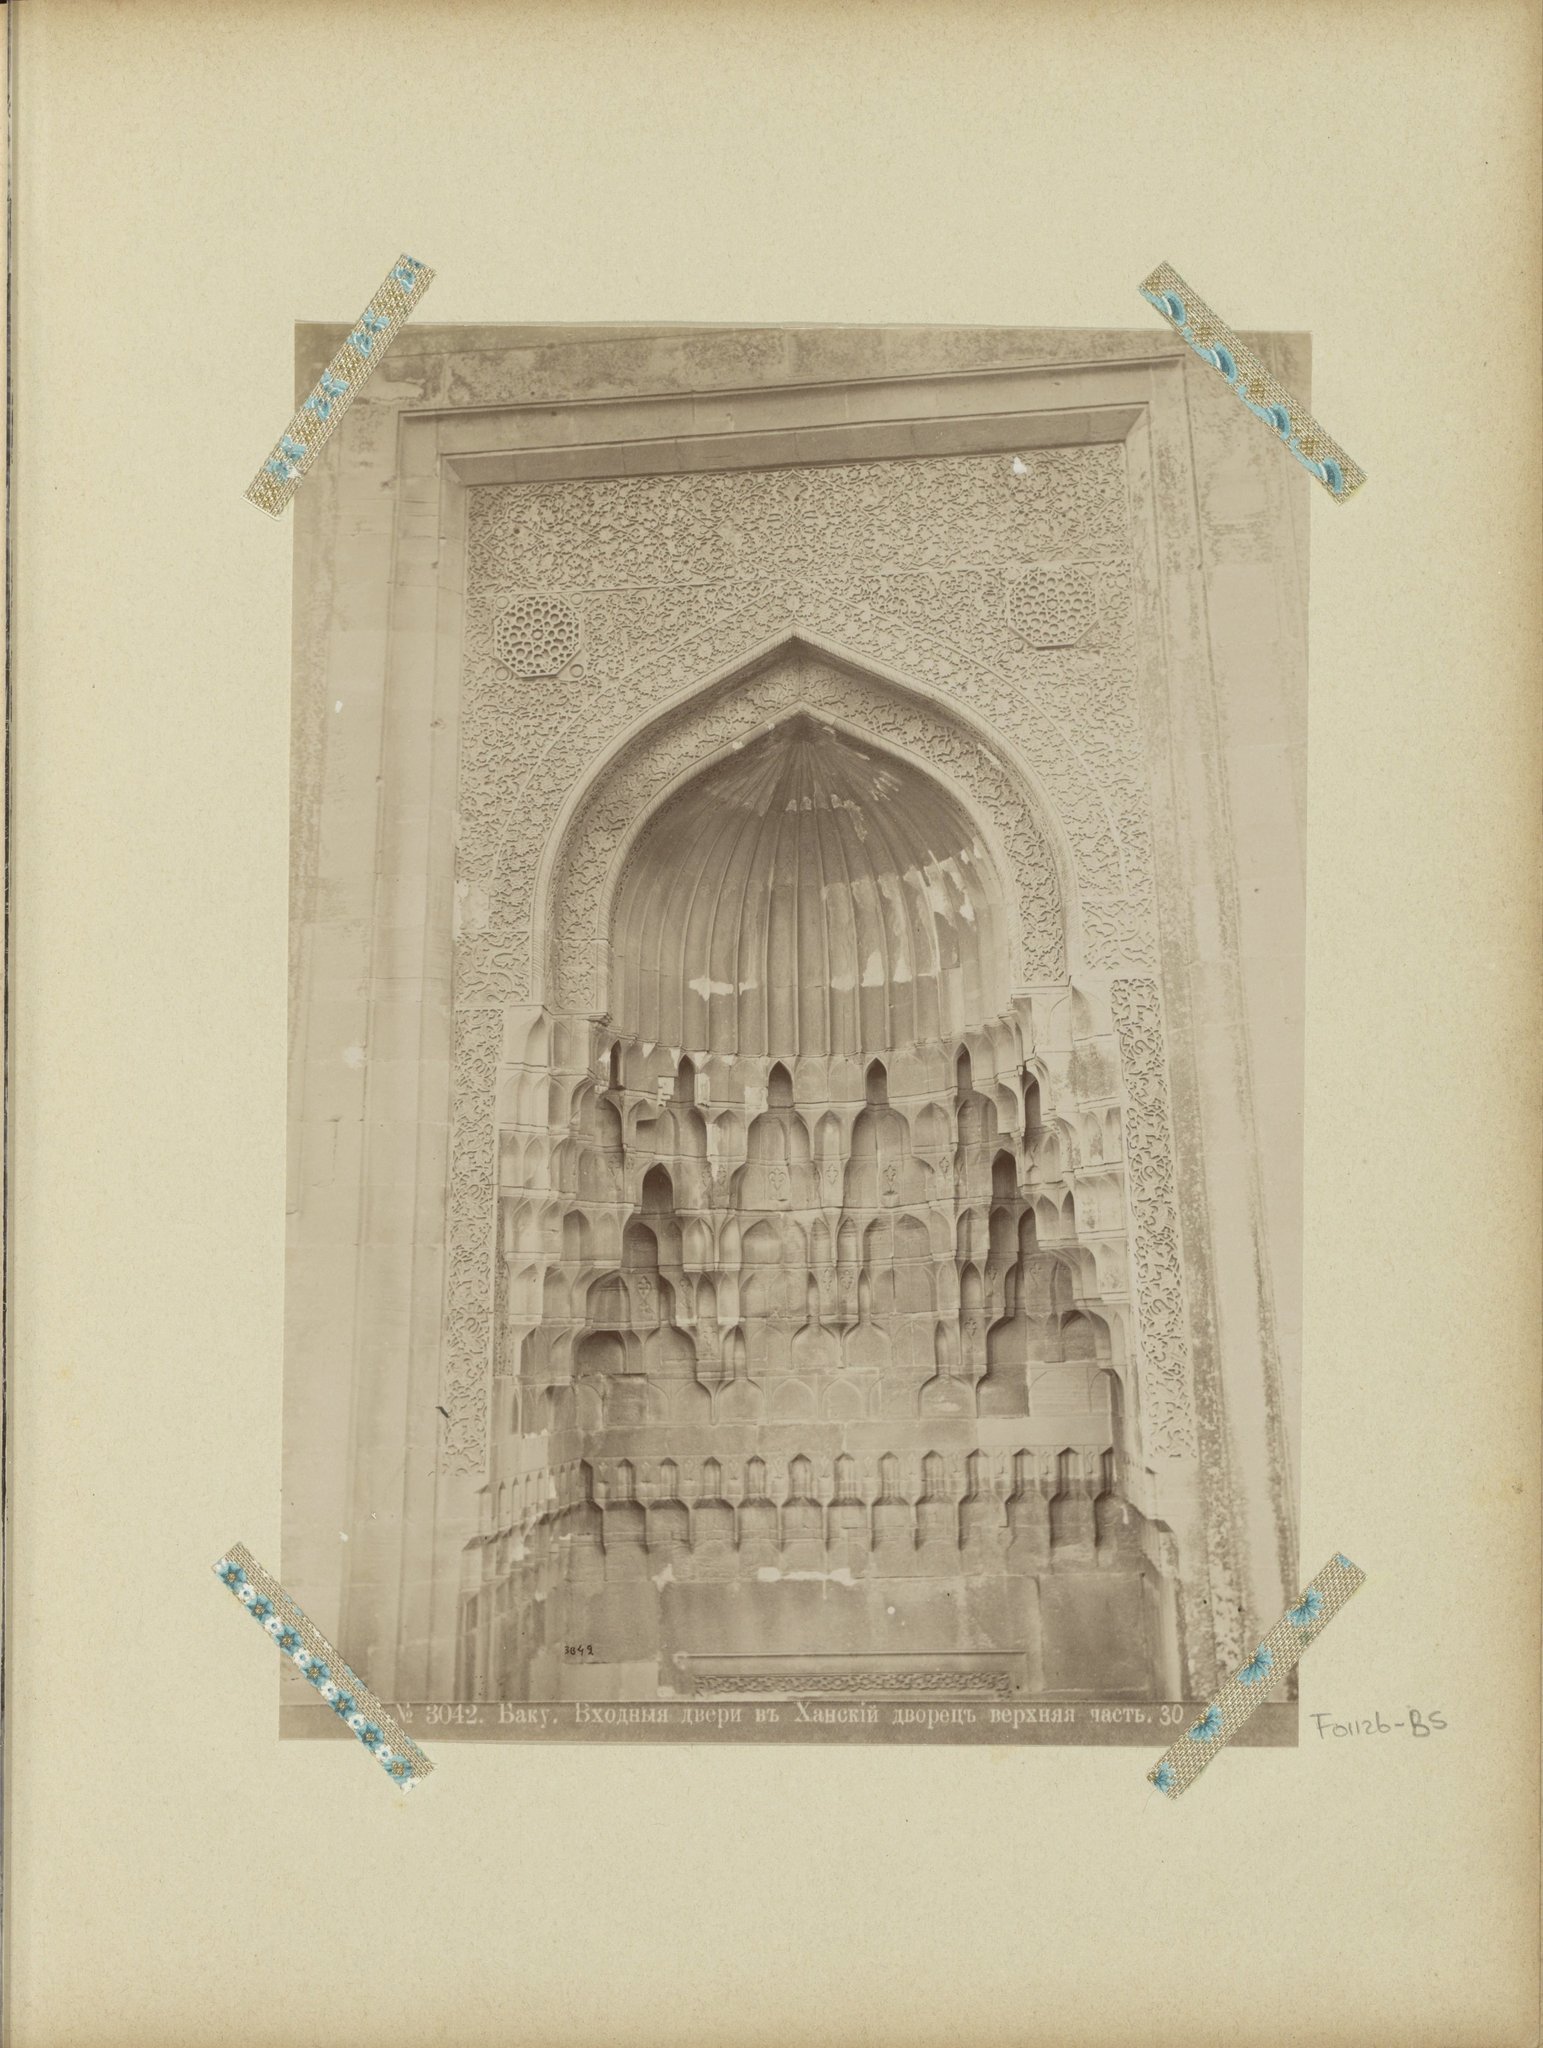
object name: photograph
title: Bovenste deel van de ingang van het paleis van de Shirvanshah in Bakoe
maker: Anonymous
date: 1890-1900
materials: photographic support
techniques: albumen print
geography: baku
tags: gate, entrance, sculpture (+ relief ~ sculpture)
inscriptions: number: ‘3042’, number: ‘30’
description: Onderdeel van Fotoalbum met opnames van bezienswaardigheden in Georgië, Sint-Petersburg en Moskou.